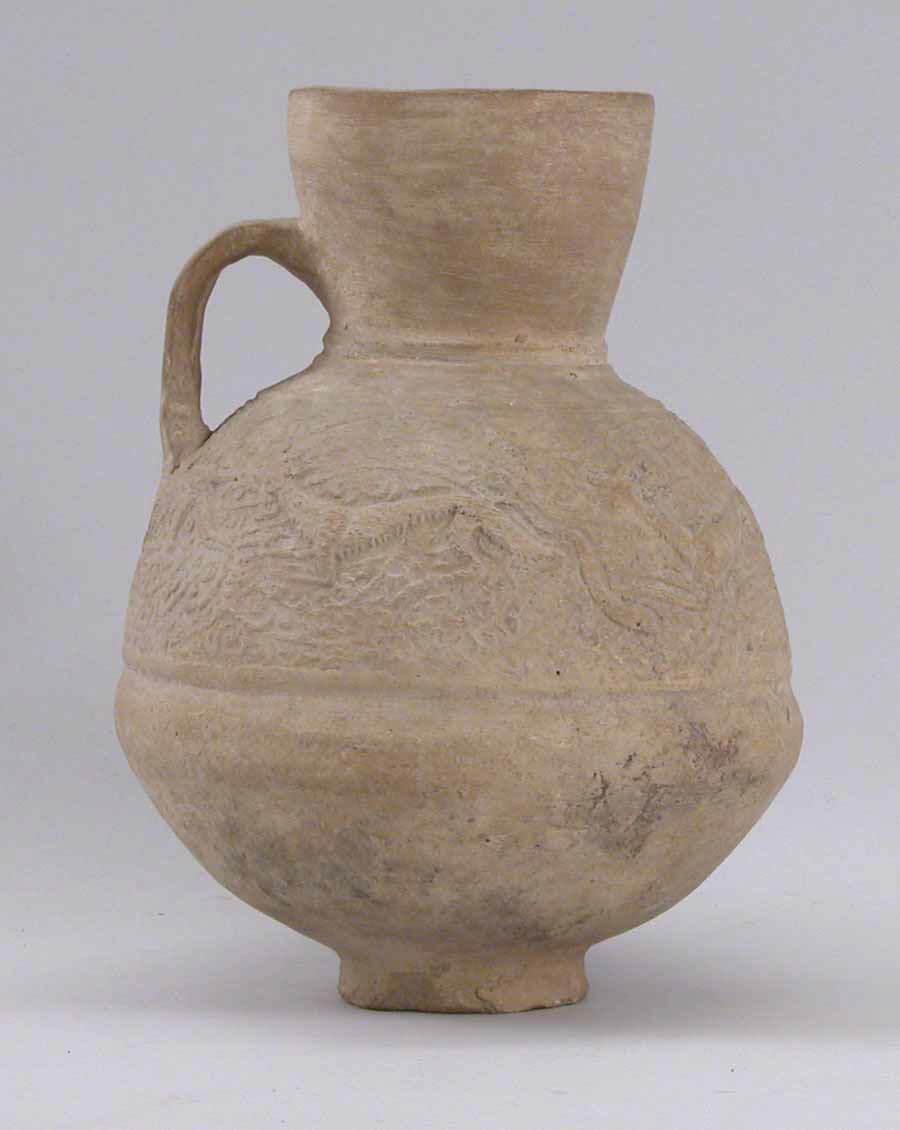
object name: ewer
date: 1101-1300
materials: earthenware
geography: iraq